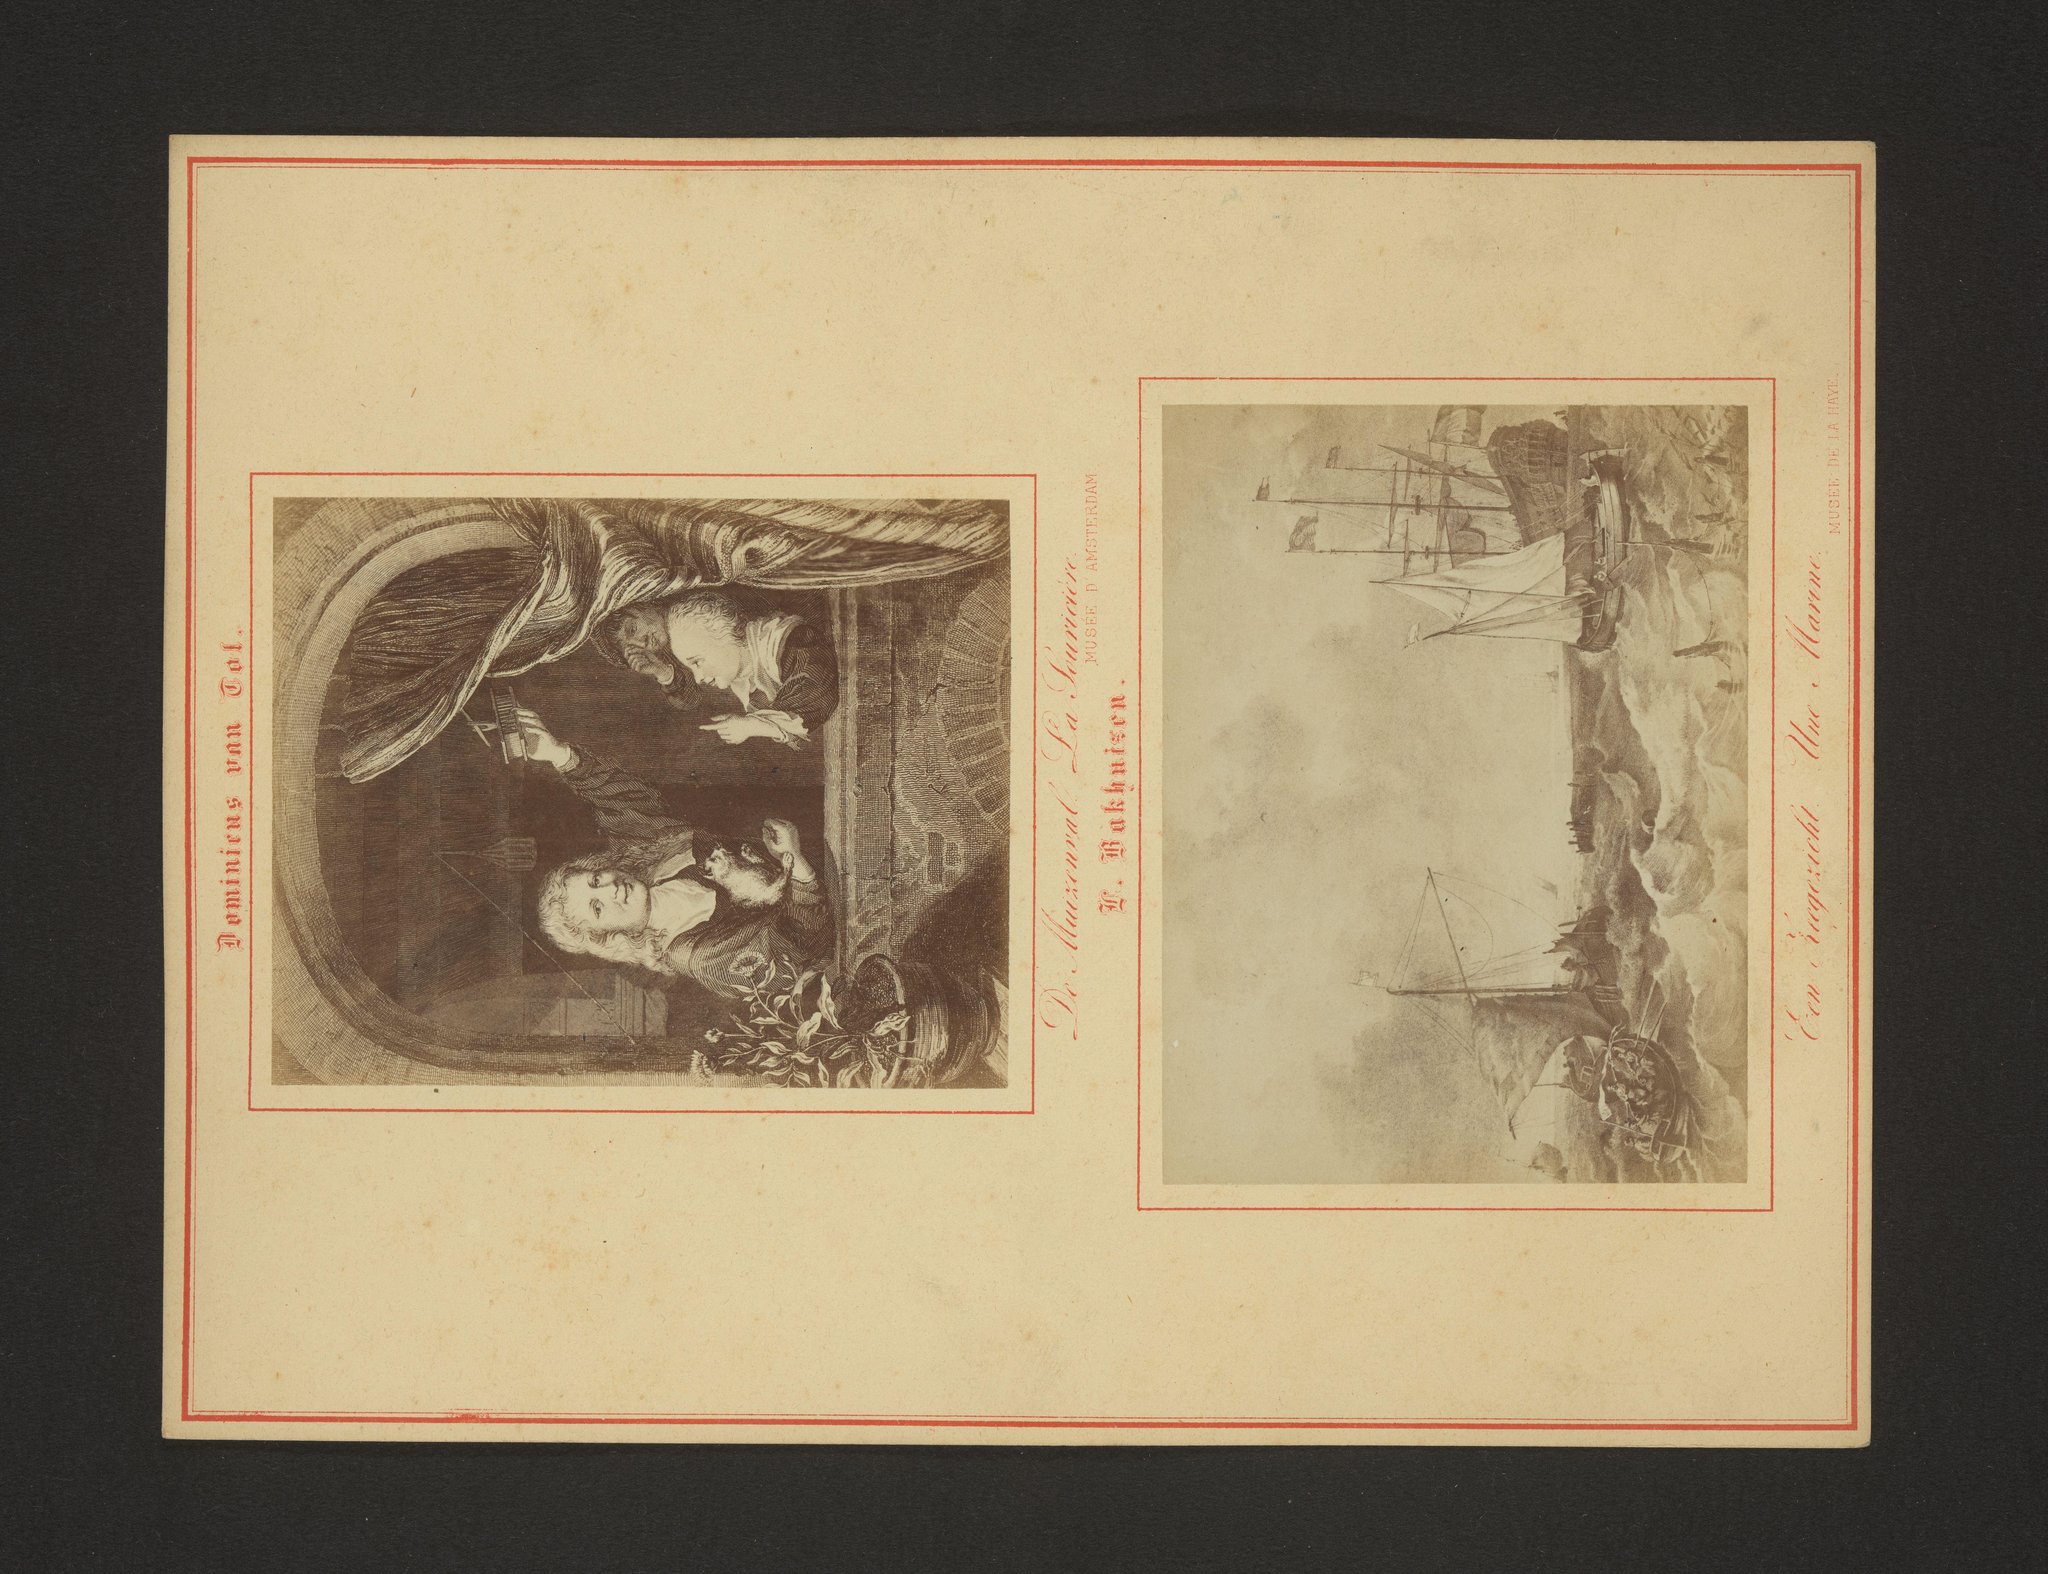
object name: photograph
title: Dominicus van Tol - De Muizenval, la souricière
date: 1866-1874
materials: cardboard, photographic support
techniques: albumen print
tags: youth, adolescent, sea (seascape), mouse trap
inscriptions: annotation: ‘Musée de La Haye’, annotation: ‘Musée d'Amsterdam’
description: Deze foto maakt deel uit van een omslag met 25 foto's.